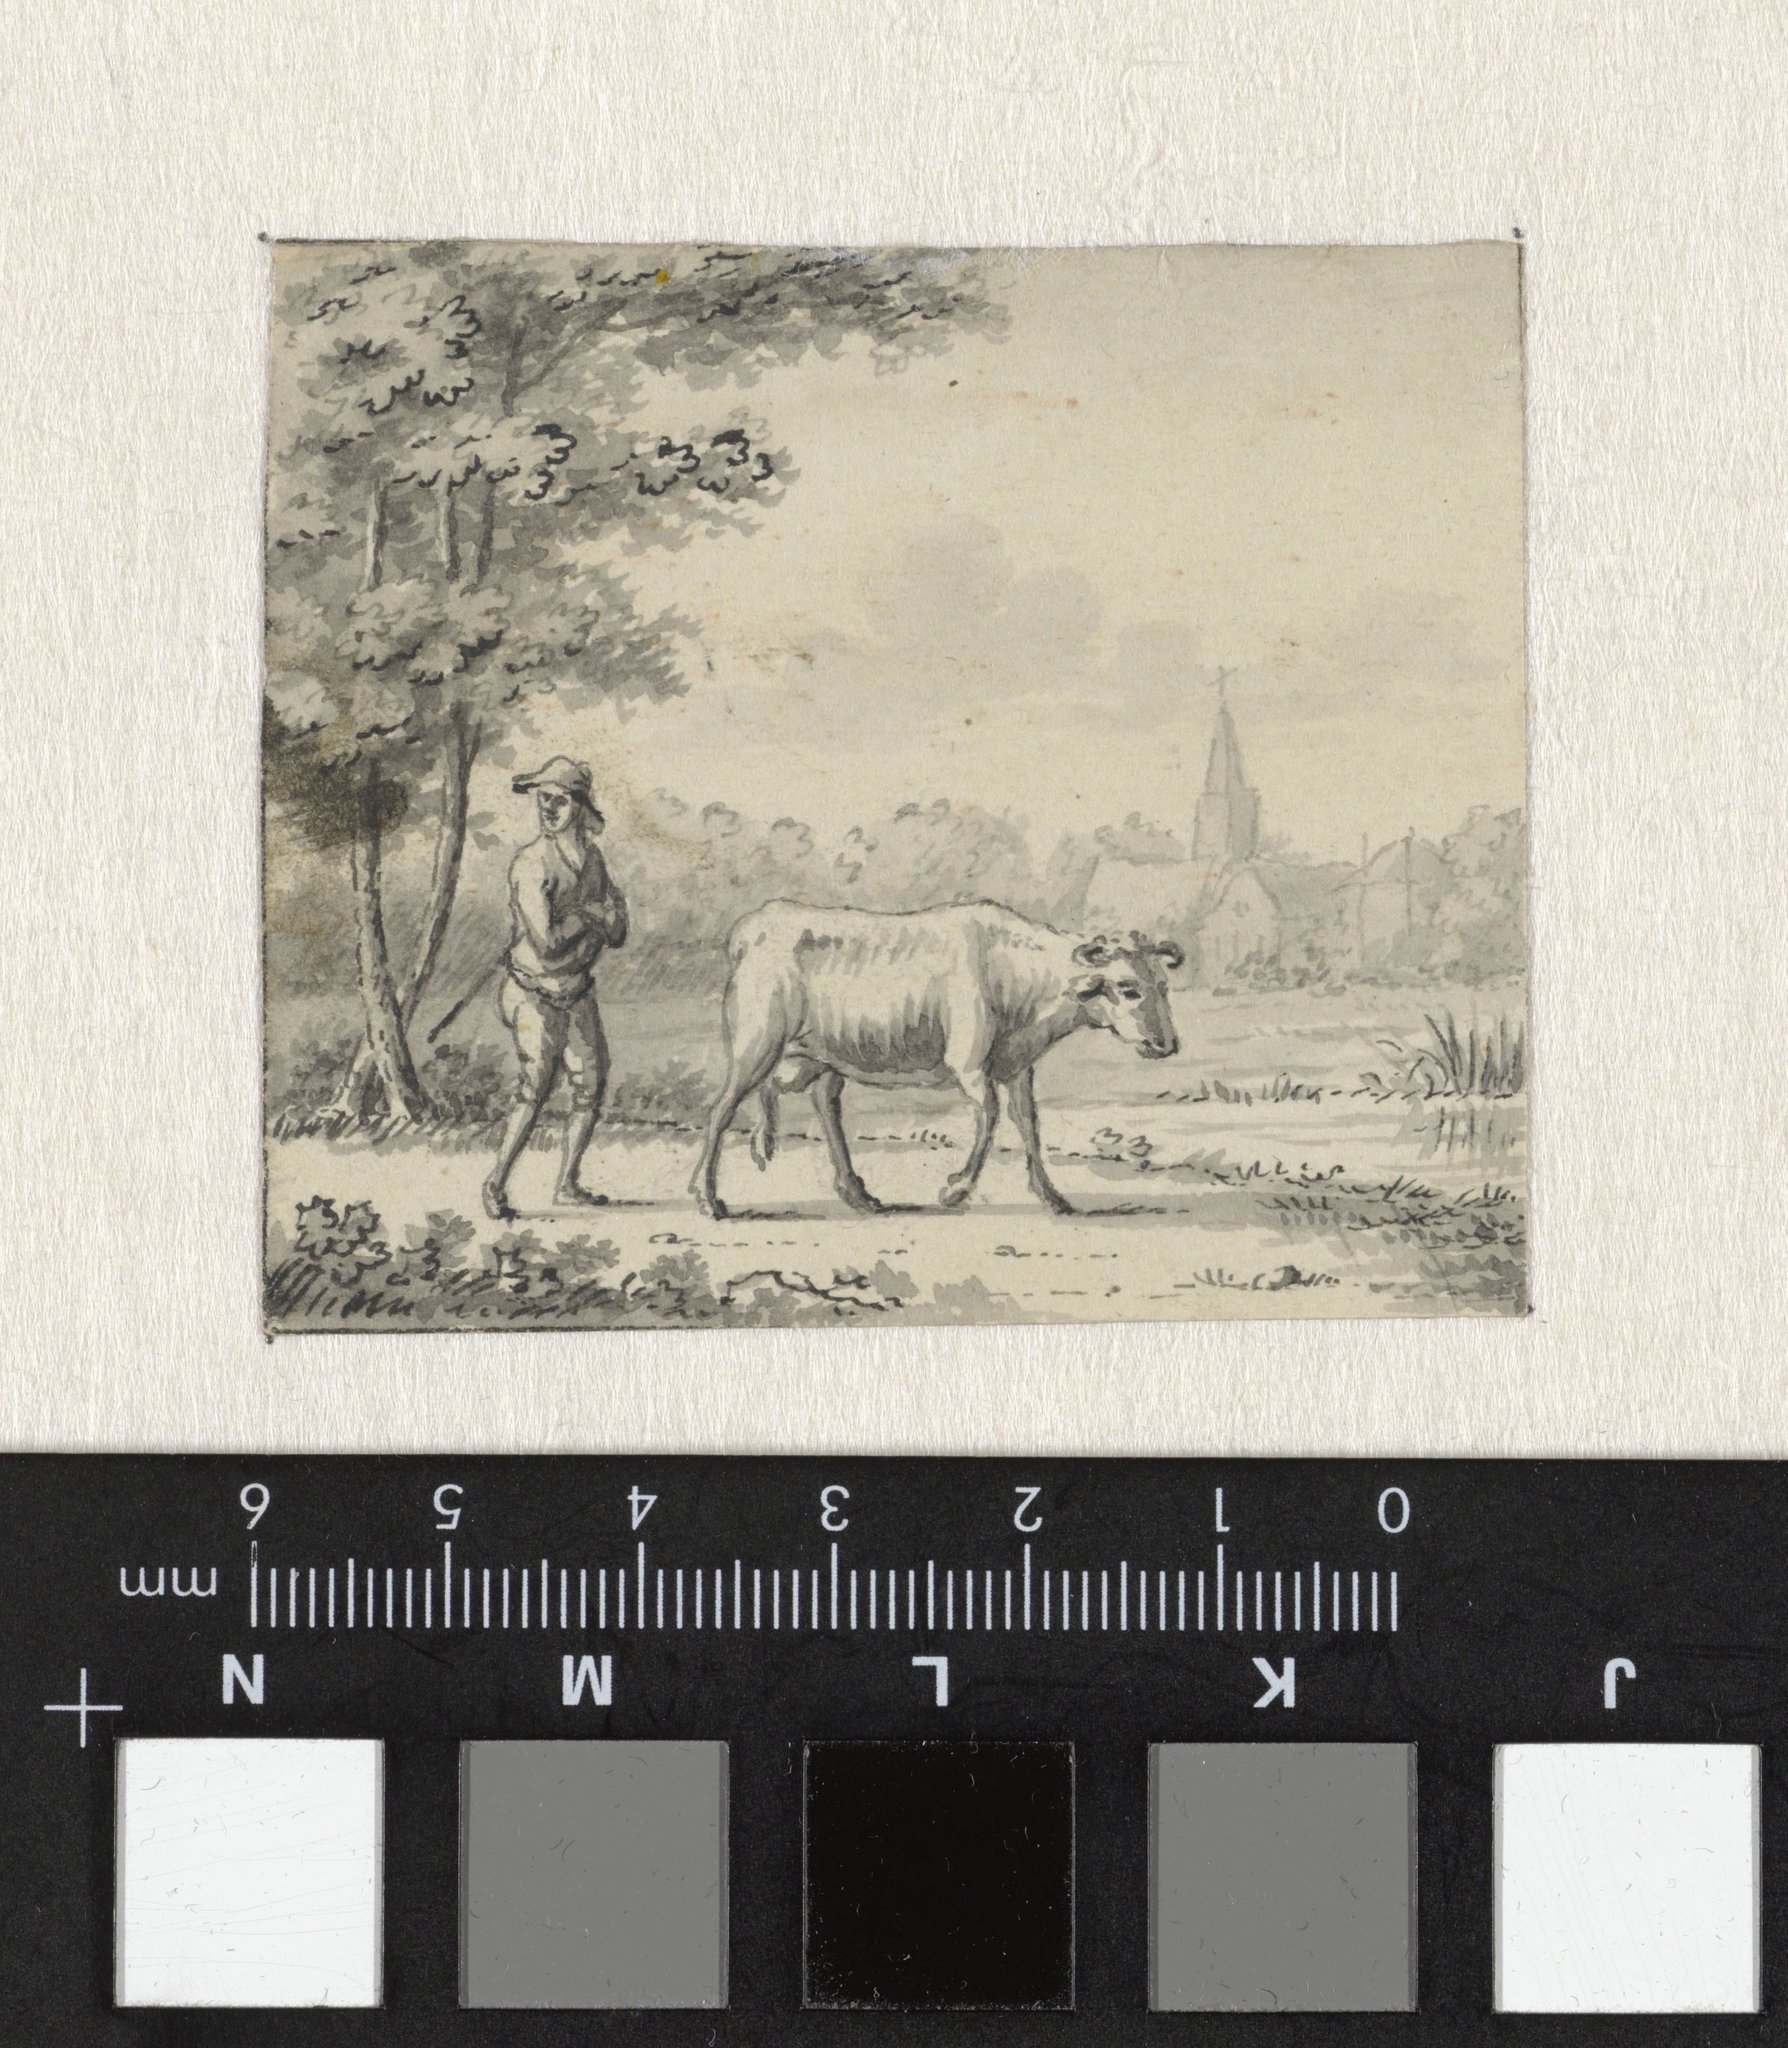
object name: design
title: Landschap met twee koeien en een schaap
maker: pieter de goeje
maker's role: draughtsman, print maker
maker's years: 1789-1859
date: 1789-1859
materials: chalk, ink, paper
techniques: brush, pen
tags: cow, sheep